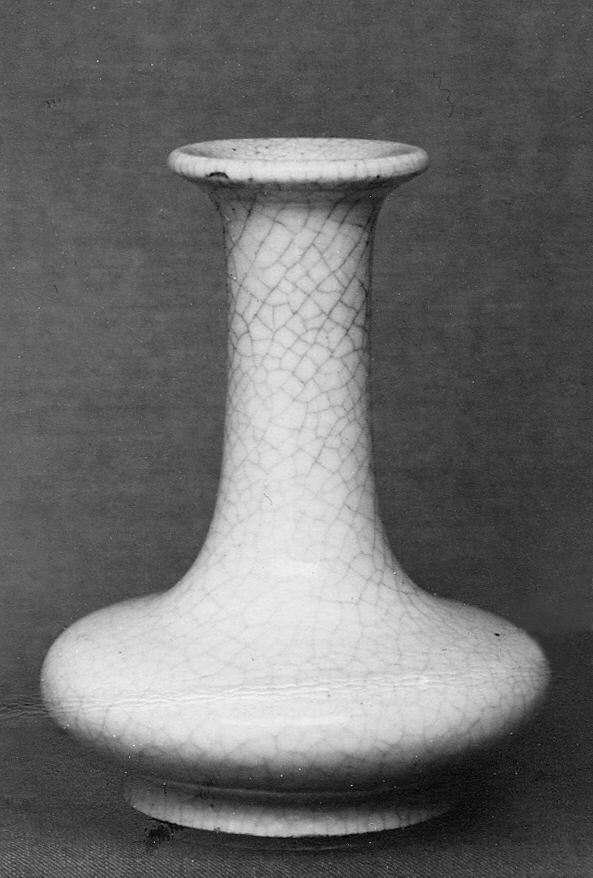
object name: vase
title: Miniature Vase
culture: chinese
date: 1801-1900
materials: soft paste porcelain